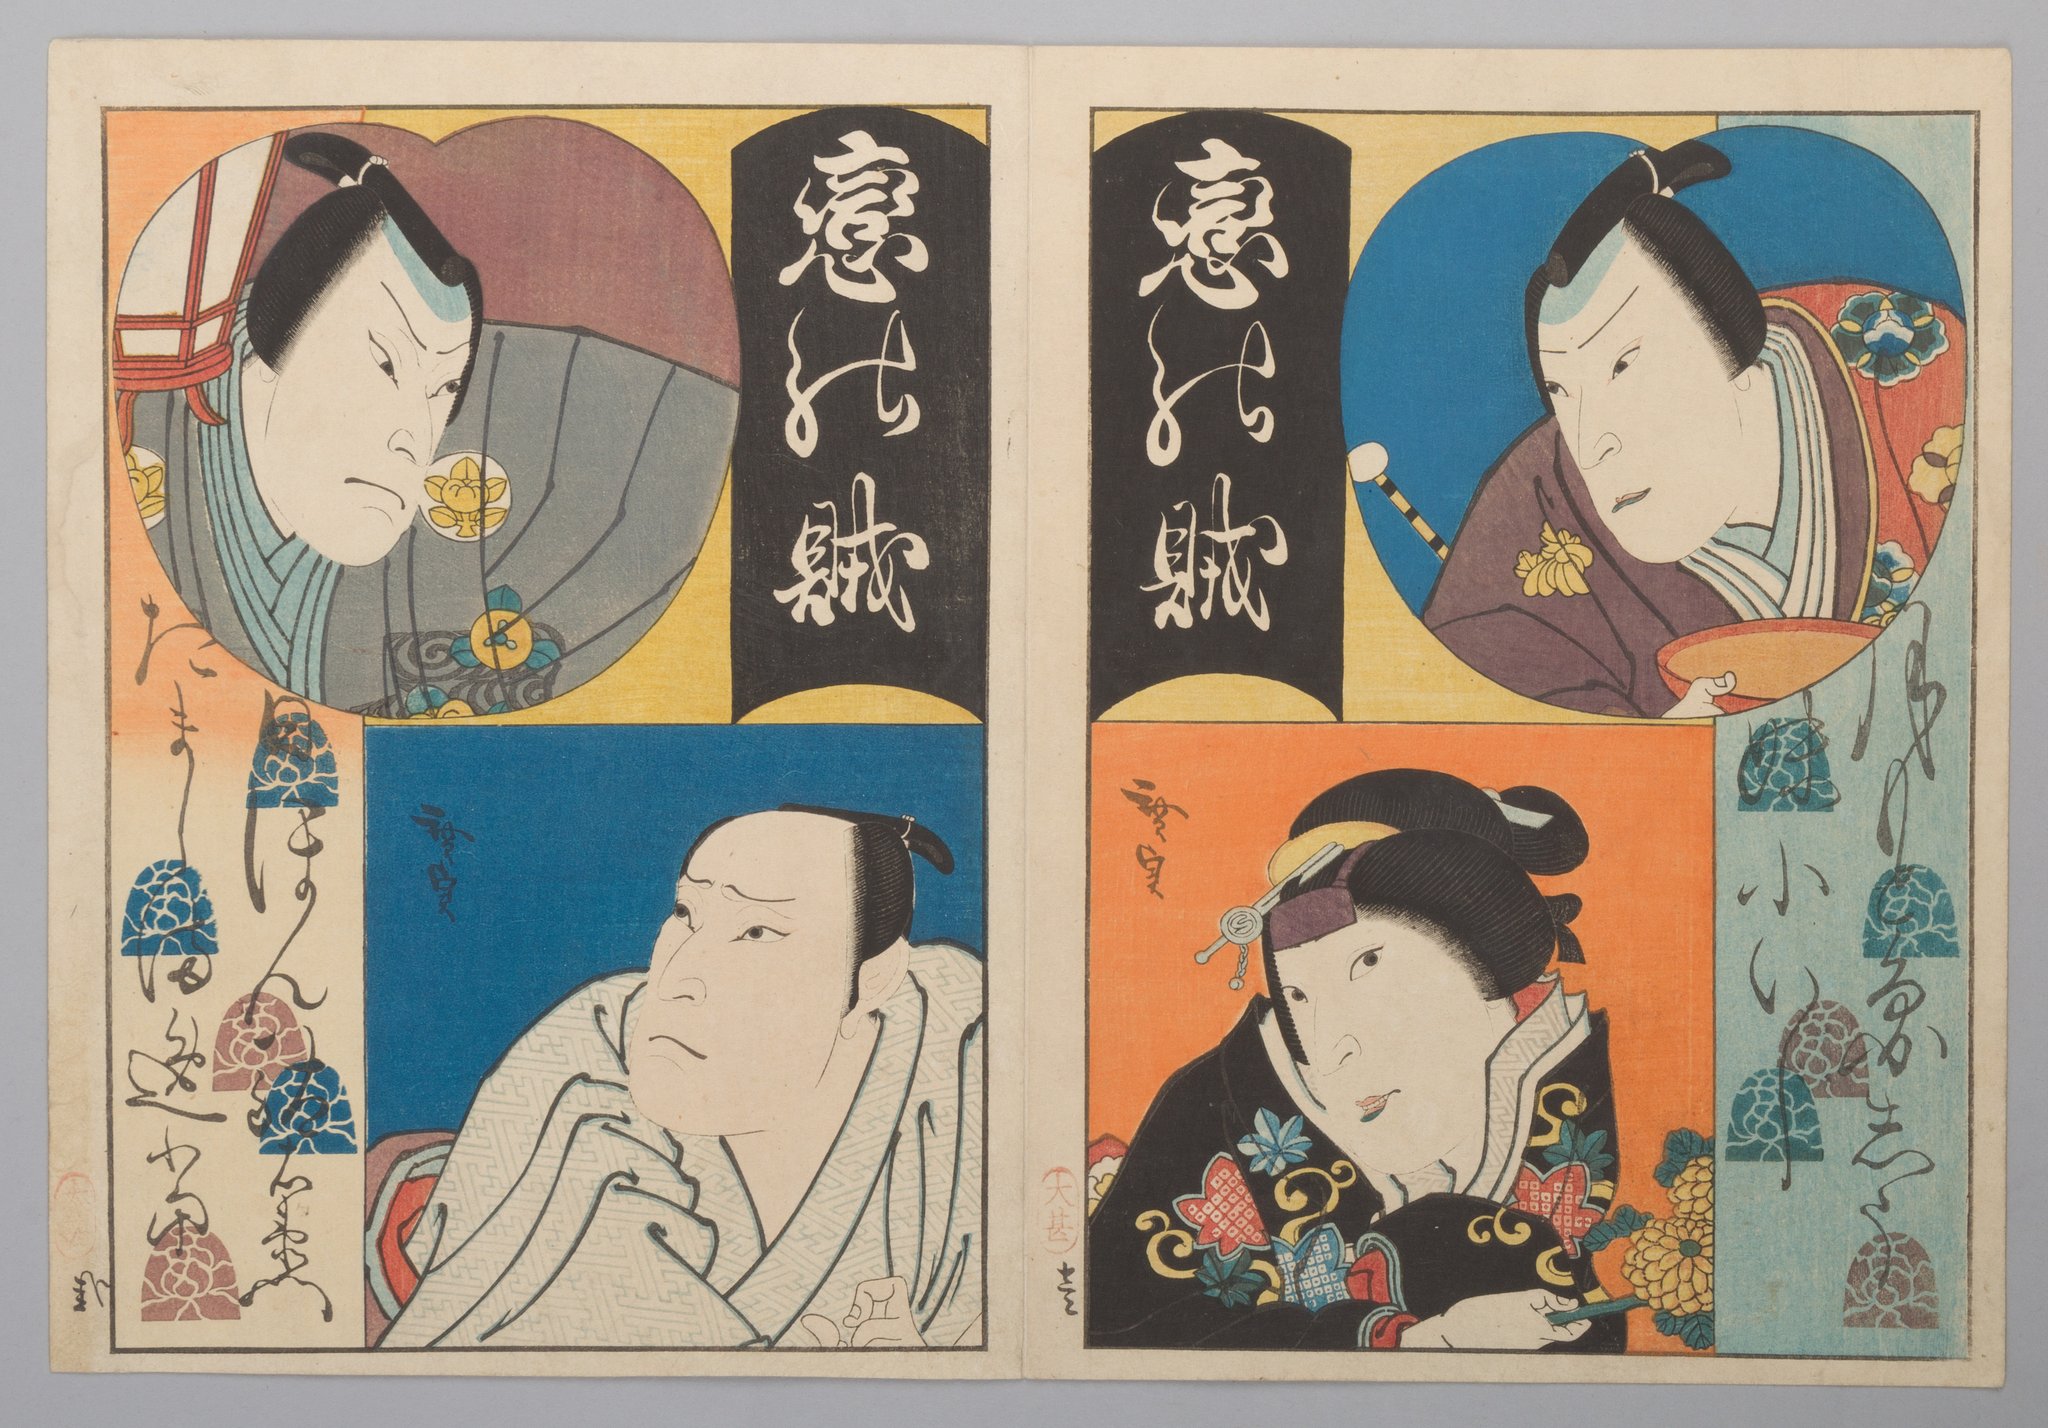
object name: woodblock print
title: Nine Prints Depicting Dual Portraits of Actors in Roles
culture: japanese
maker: utagawa hirosada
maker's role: artist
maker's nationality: japanese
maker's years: 1825-1875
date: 1852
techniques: woodblock print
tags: men,portraits,actors